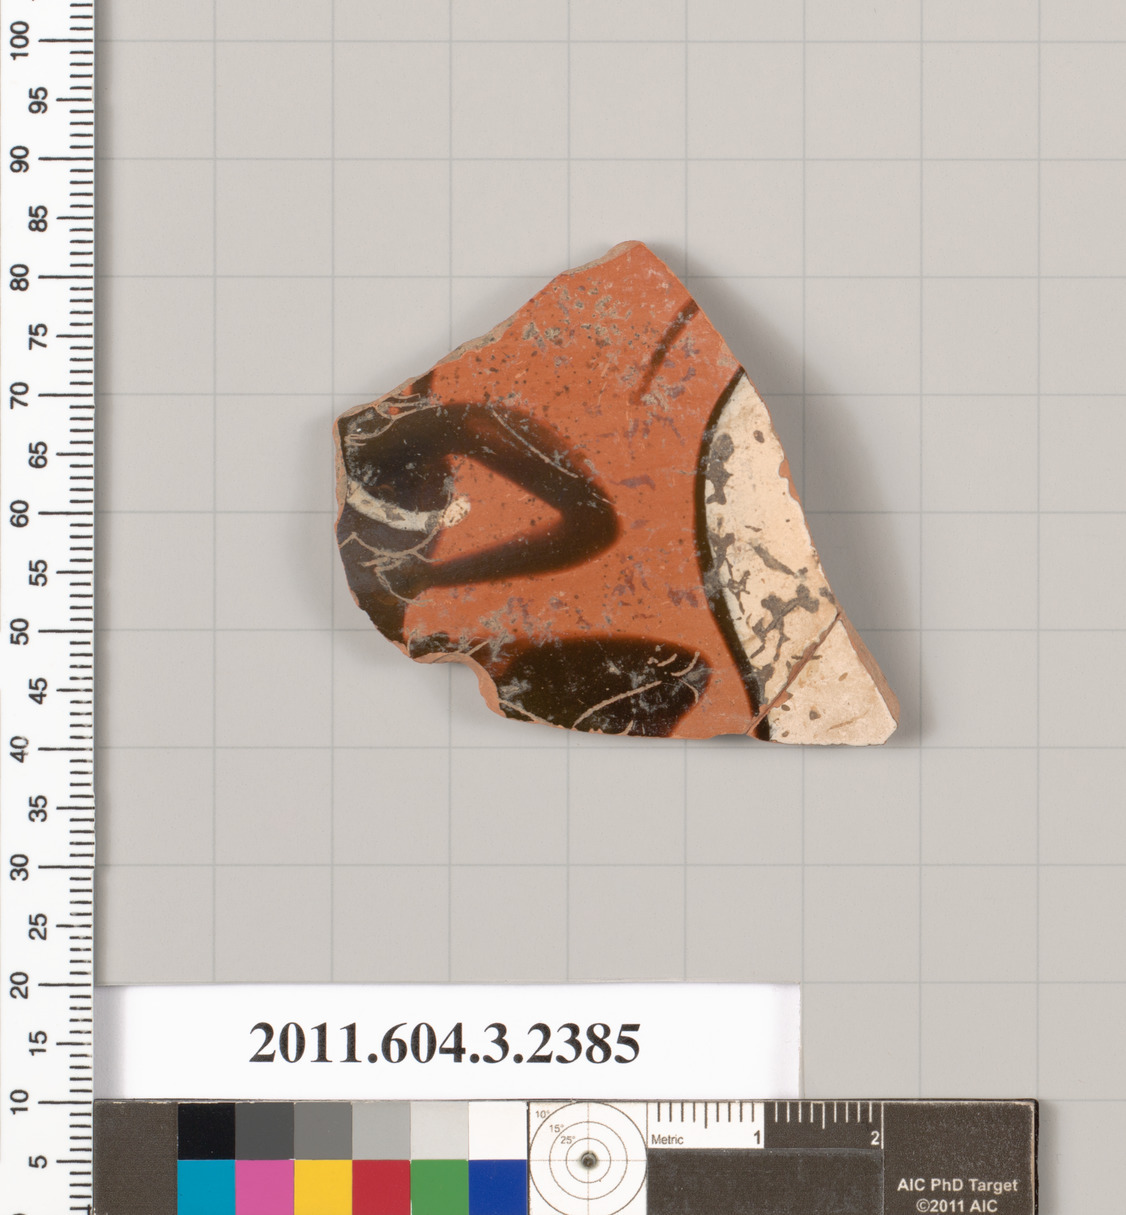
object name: kylix fragment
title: Terracotta fragment of a kylix: eye-cup (drinking cup)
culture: greek, attic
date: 525-501 BCE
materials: terracotta